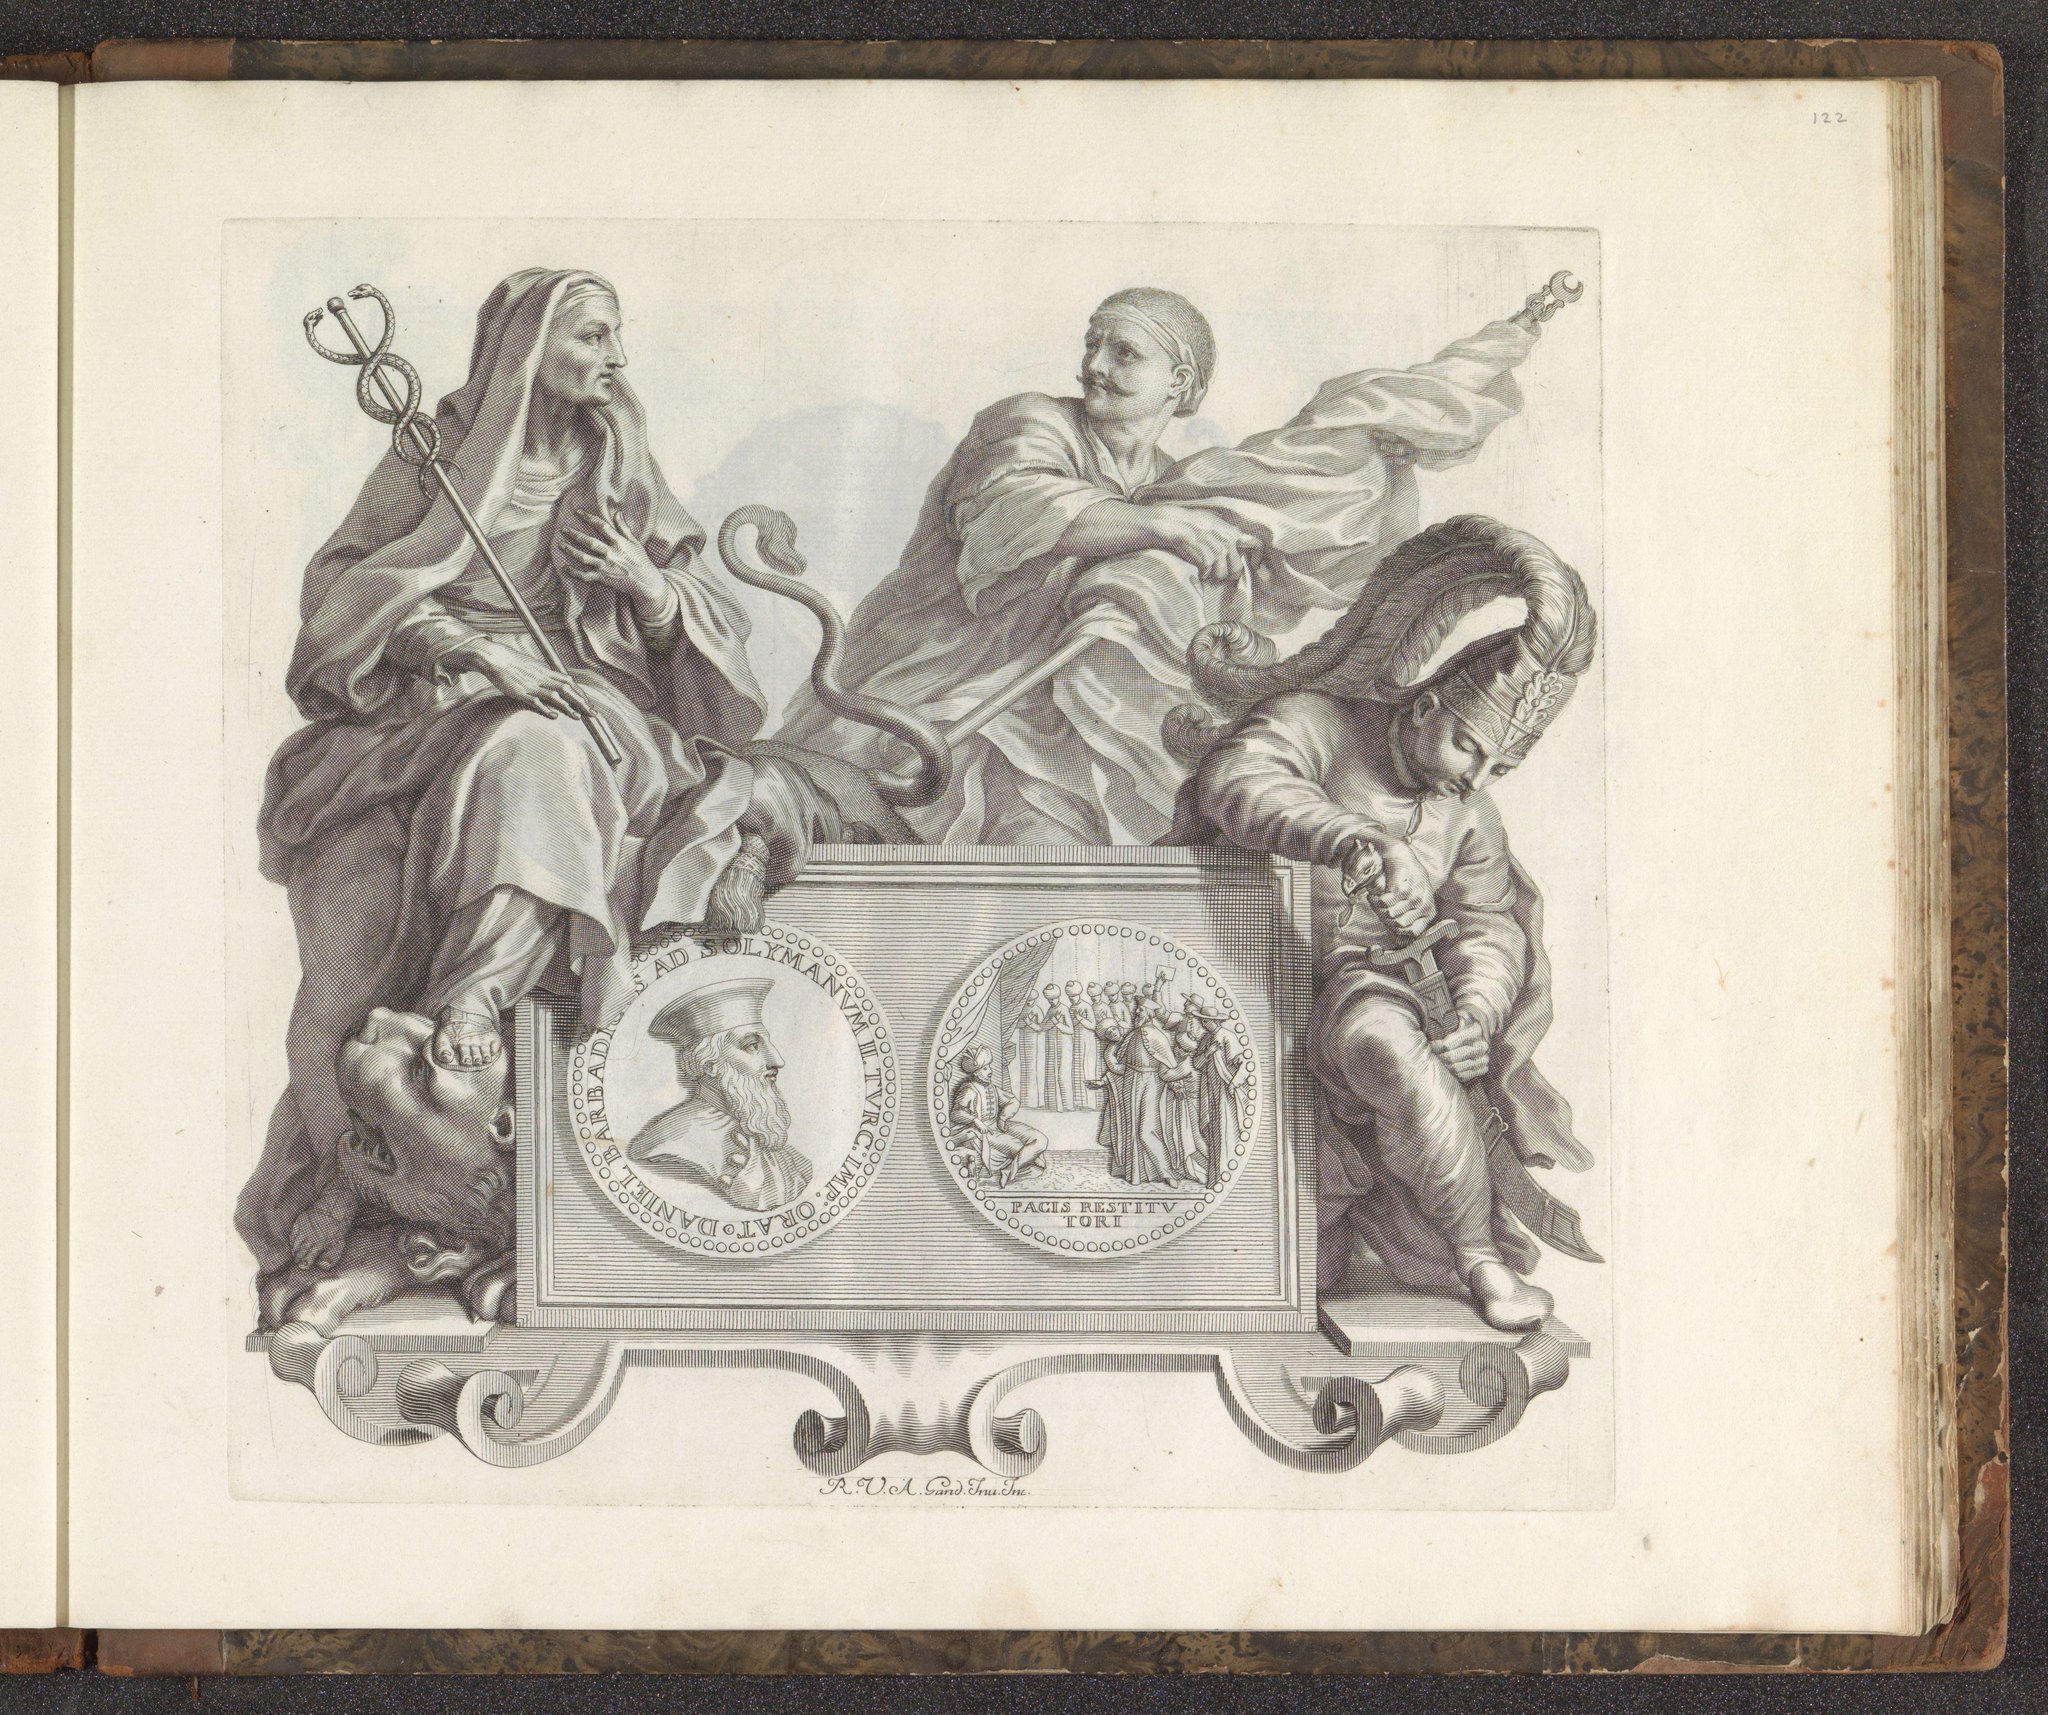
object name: print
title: Portret van Daniele Barbarigo met de personificatie van de Kracht van Welsprekendheid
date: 1673-1743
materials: paper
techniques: engraving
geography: rome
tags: venice, asiatic races and peoples: turks, power of eloquence; 'forza sottoposta all'eloquenza' (ripa), medal (considered as a piece of sculpture, regardless of its specific function), caduceus (staff with two snakes, attribute of mercury), beasts of prey, predatory animals: lion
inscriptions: collector's mark: Lugt 2228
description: Voetstuk in de vorm van een cartouche. Daarop een medaillon met op de voorzijde het portret van Daniele Barbarigo. Op de achterkant staat Daniele als Venetiaans woordvoerder voor sultan Süleyman II. Daaronder de tekst: Facis Restitutori. Het voetstuk wordt geflankeerd door Kracht van Welsprekendheid. Het betreft een oudere vrouw met een caduceus of slangenstaf in de hand en een leeuw onder haar voeten. Welsprekendheid laat twee Ottomaanse mannen afdruipen. De een neemt een vaandel mee. De andere steekt zijn zwaard terug in de schede. De prent maakt deel uit van een album.